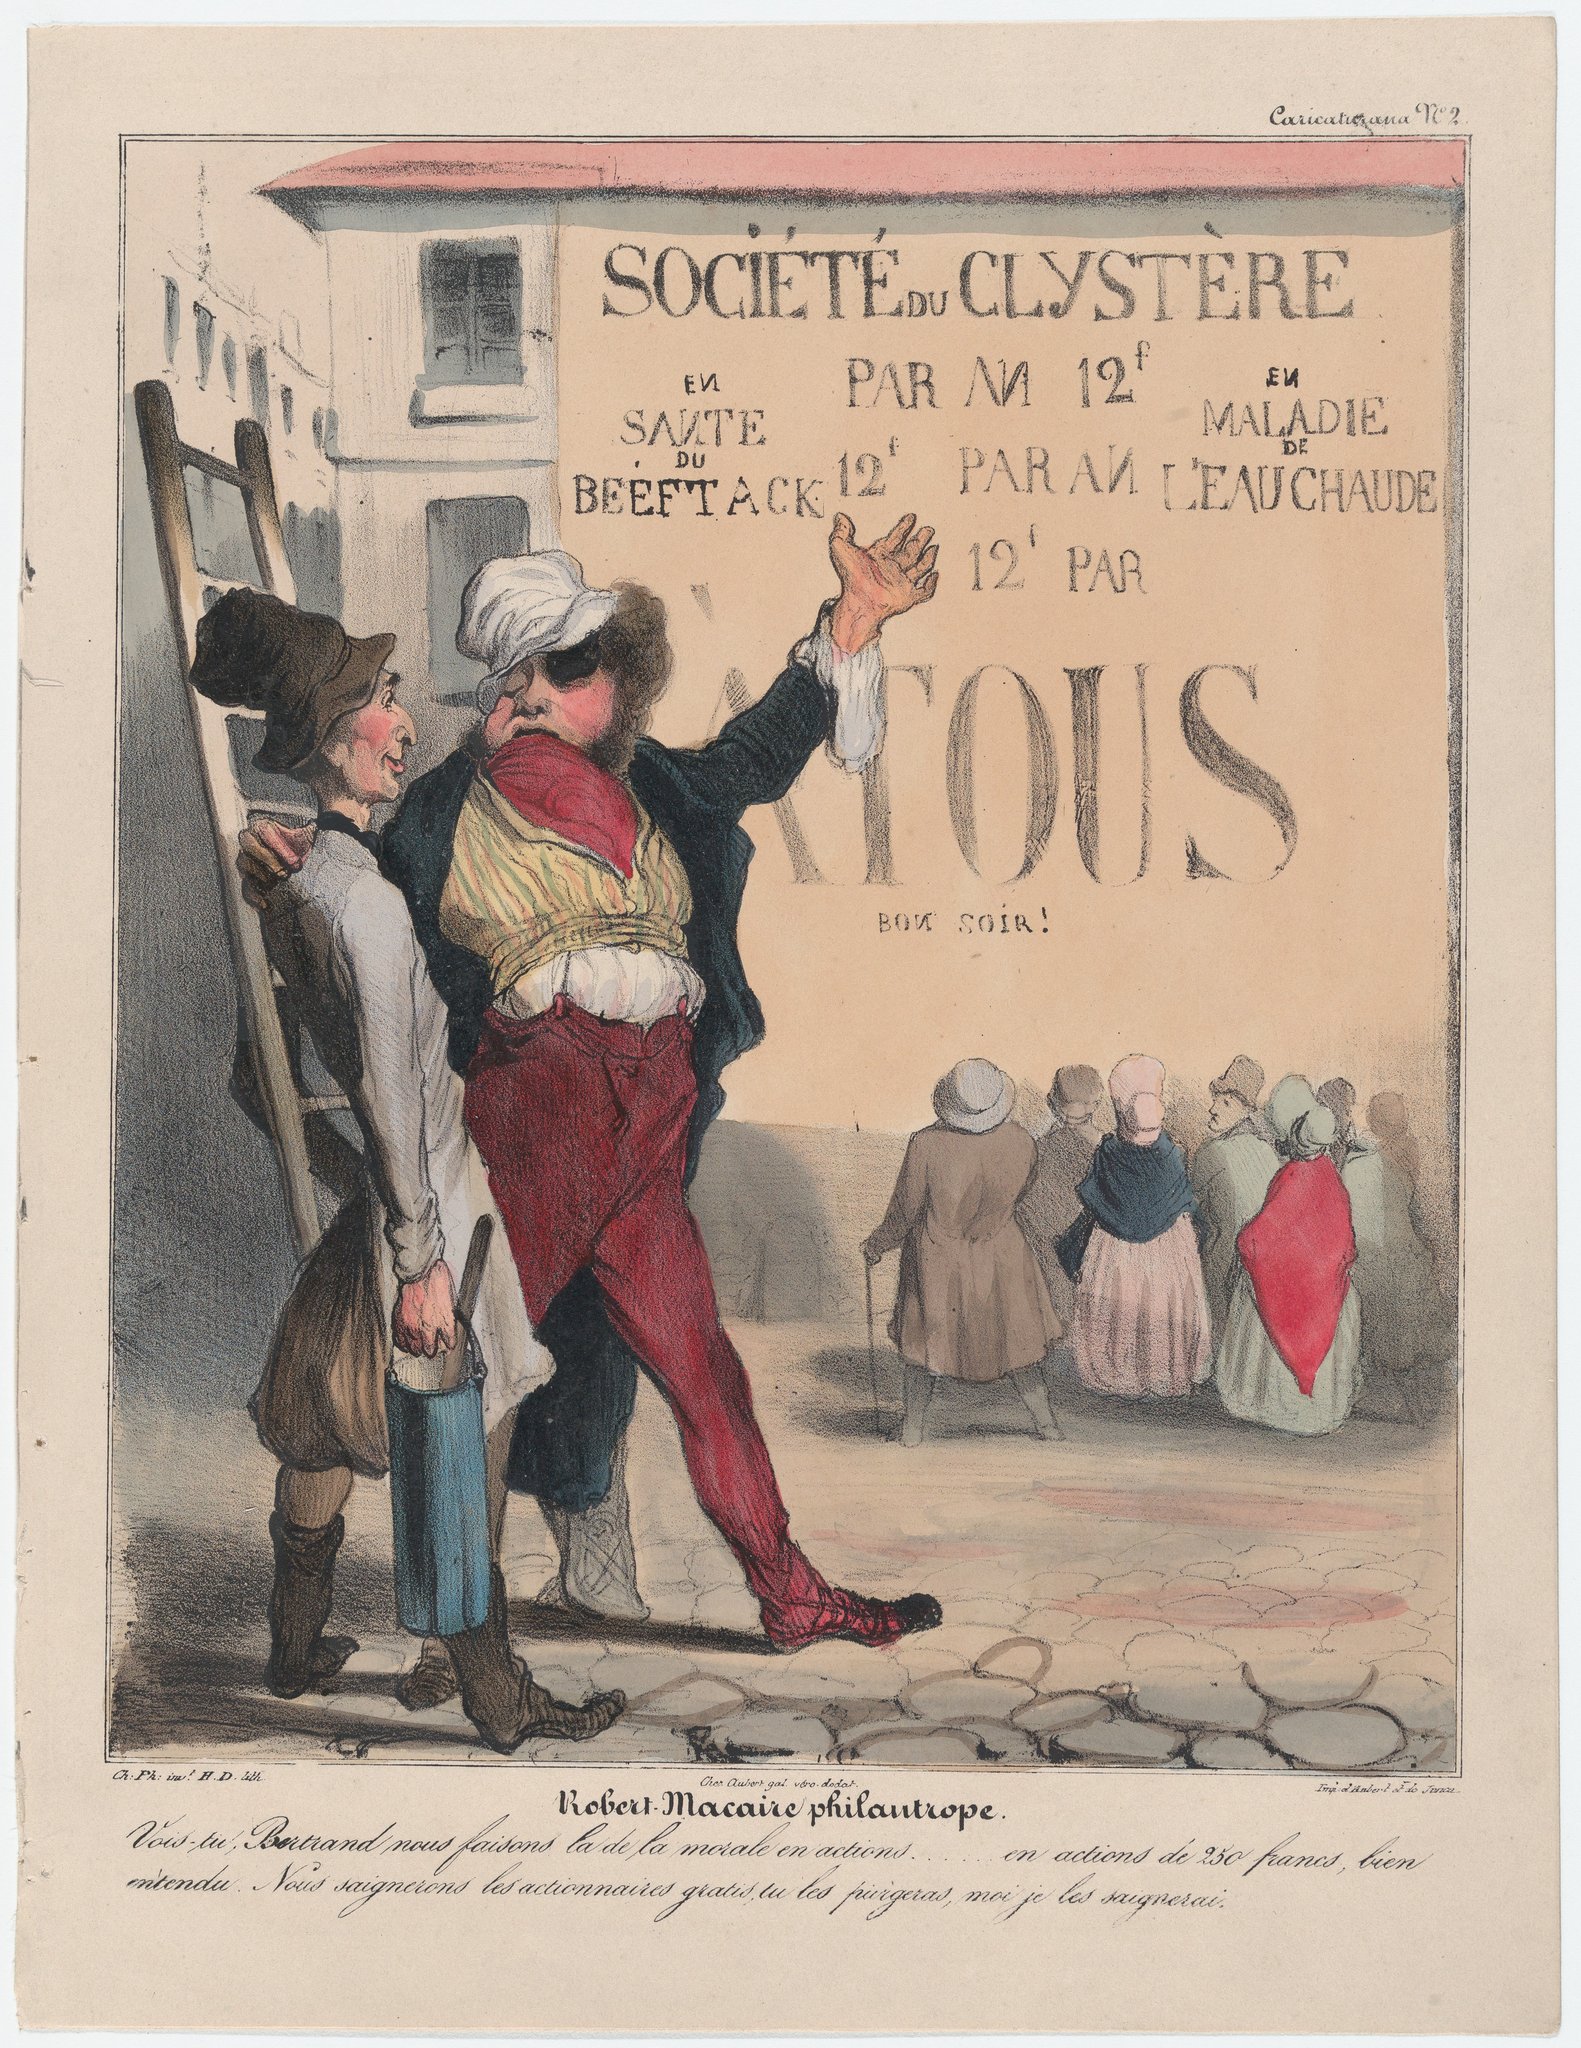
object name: print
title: Plate 2: Robert Macaire, philanthropist, from 'Caricaturana,' published in Les Robert Macaires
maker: honoré daumier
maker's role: artist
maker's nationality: french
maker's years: 1808-1879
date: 1838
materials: paper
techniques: lithograph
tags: satire,men